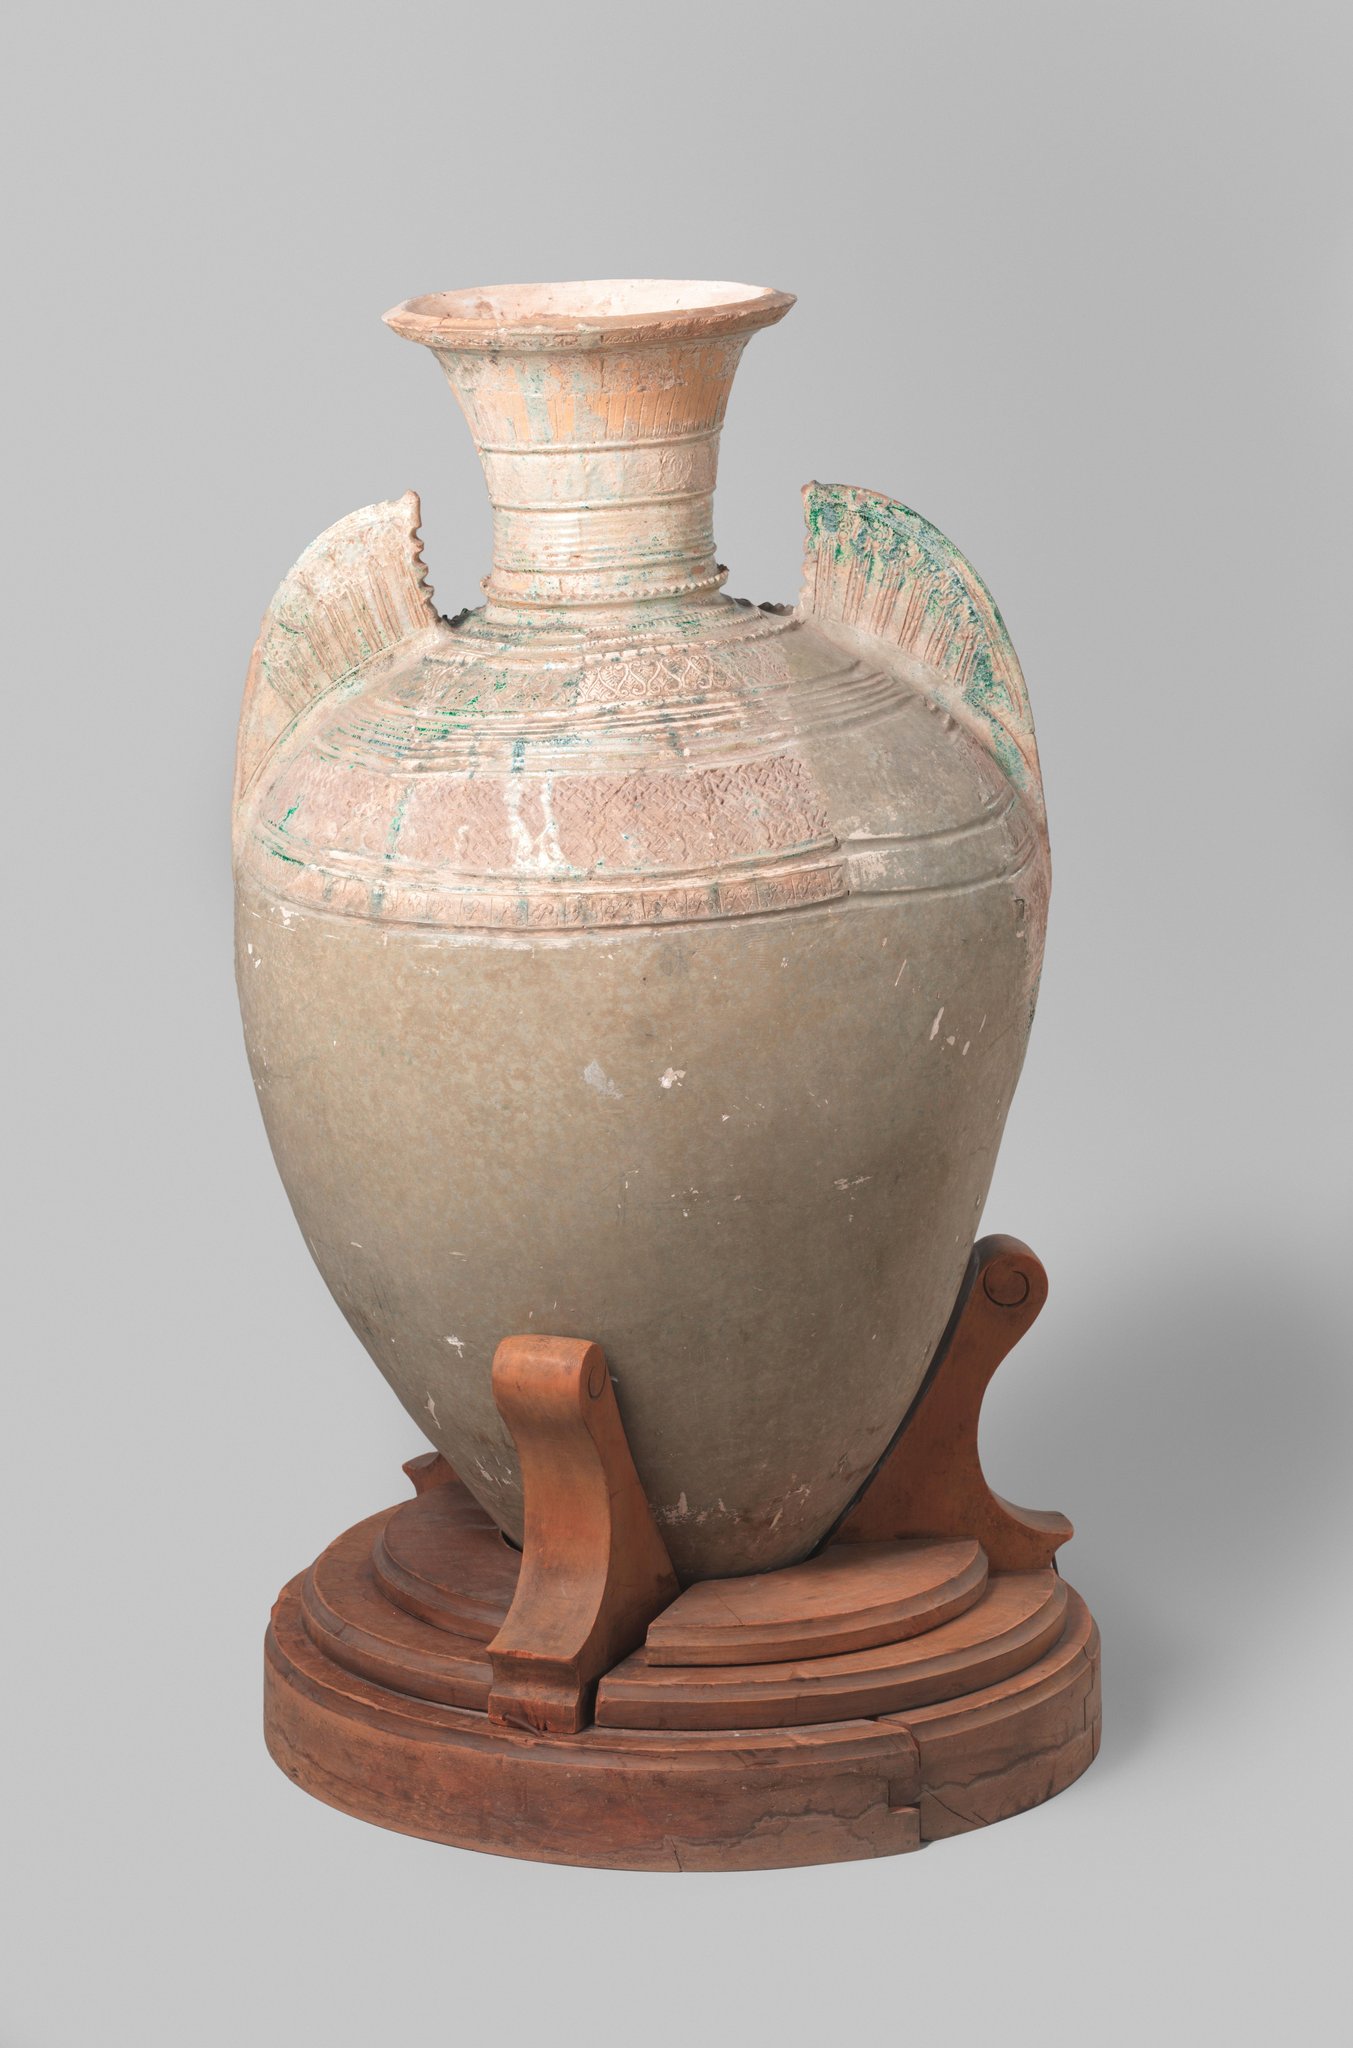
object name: vase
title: Voet van hout voor vaas met een eivormig lichaam met brede wijd uitstaande hals en twee hoge, gekartelde, platte oren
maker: Anonymous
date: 1400-1500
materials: iron, wood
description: Houten voet, cirkelvormig met drie lagen, trapsgewijs. Met drie steunen waarin de vaas geklemd wordt.